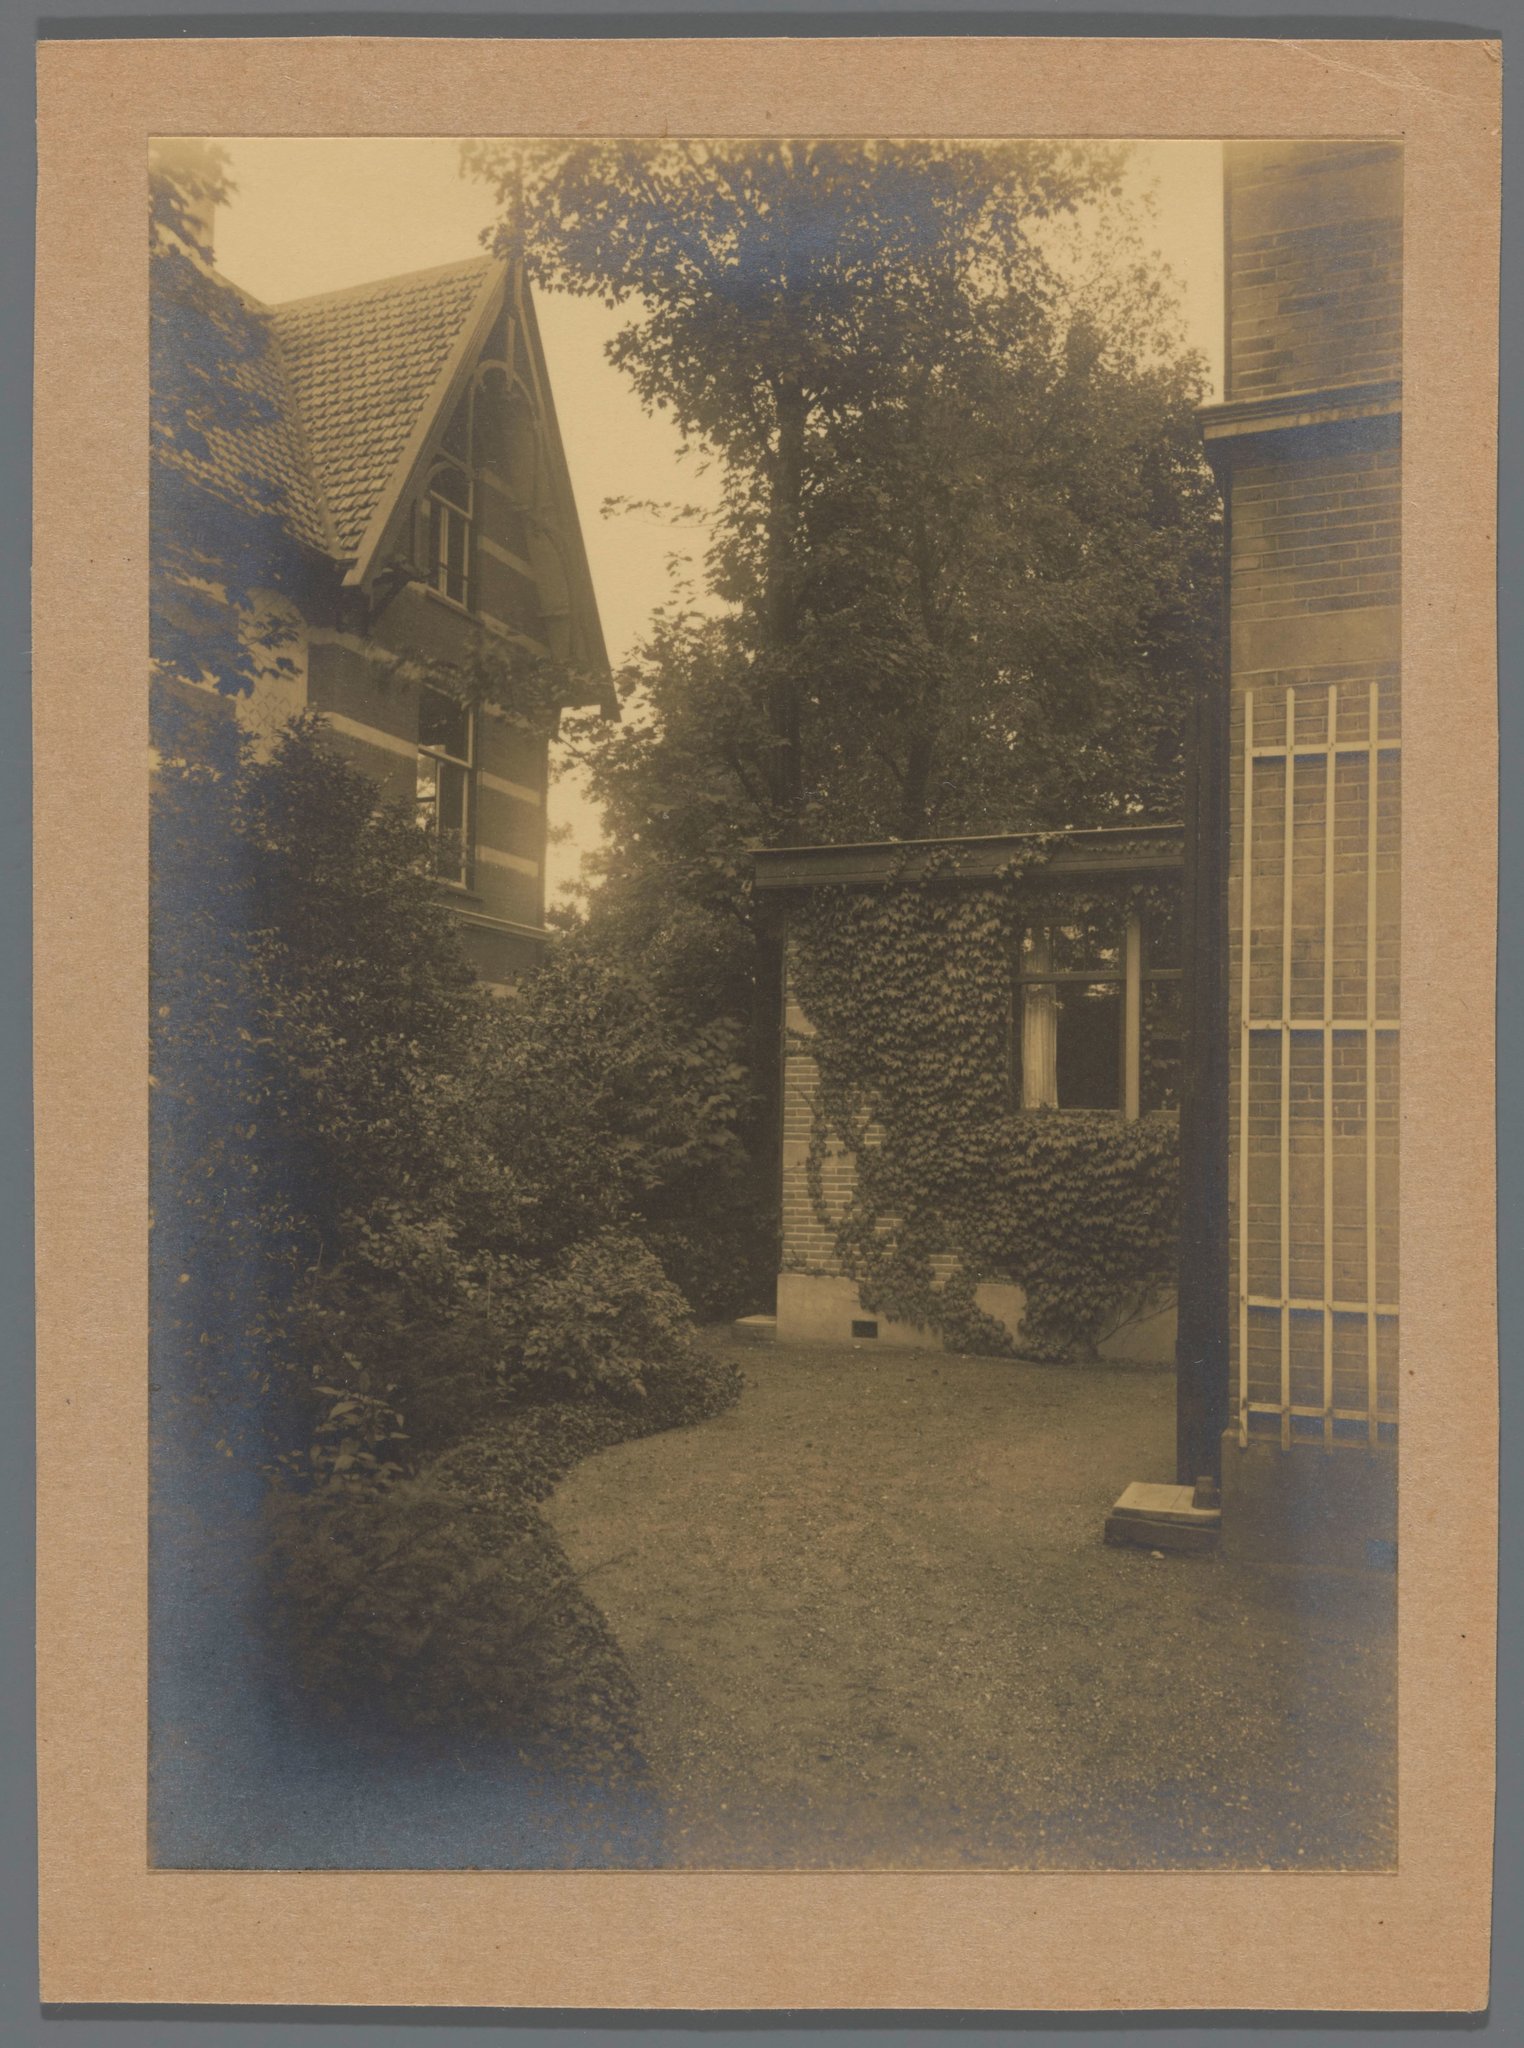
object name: photograph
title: Gezicht op een tuin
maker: cornelia hendrika jonker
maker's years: 1874-1924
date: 1915-1940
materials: cardboard, photographic support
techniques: gelatin silver print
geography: bussum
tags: garden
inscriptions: annotation: ‘Tuin buurman/ Bussum/ Woning L. Jonker’